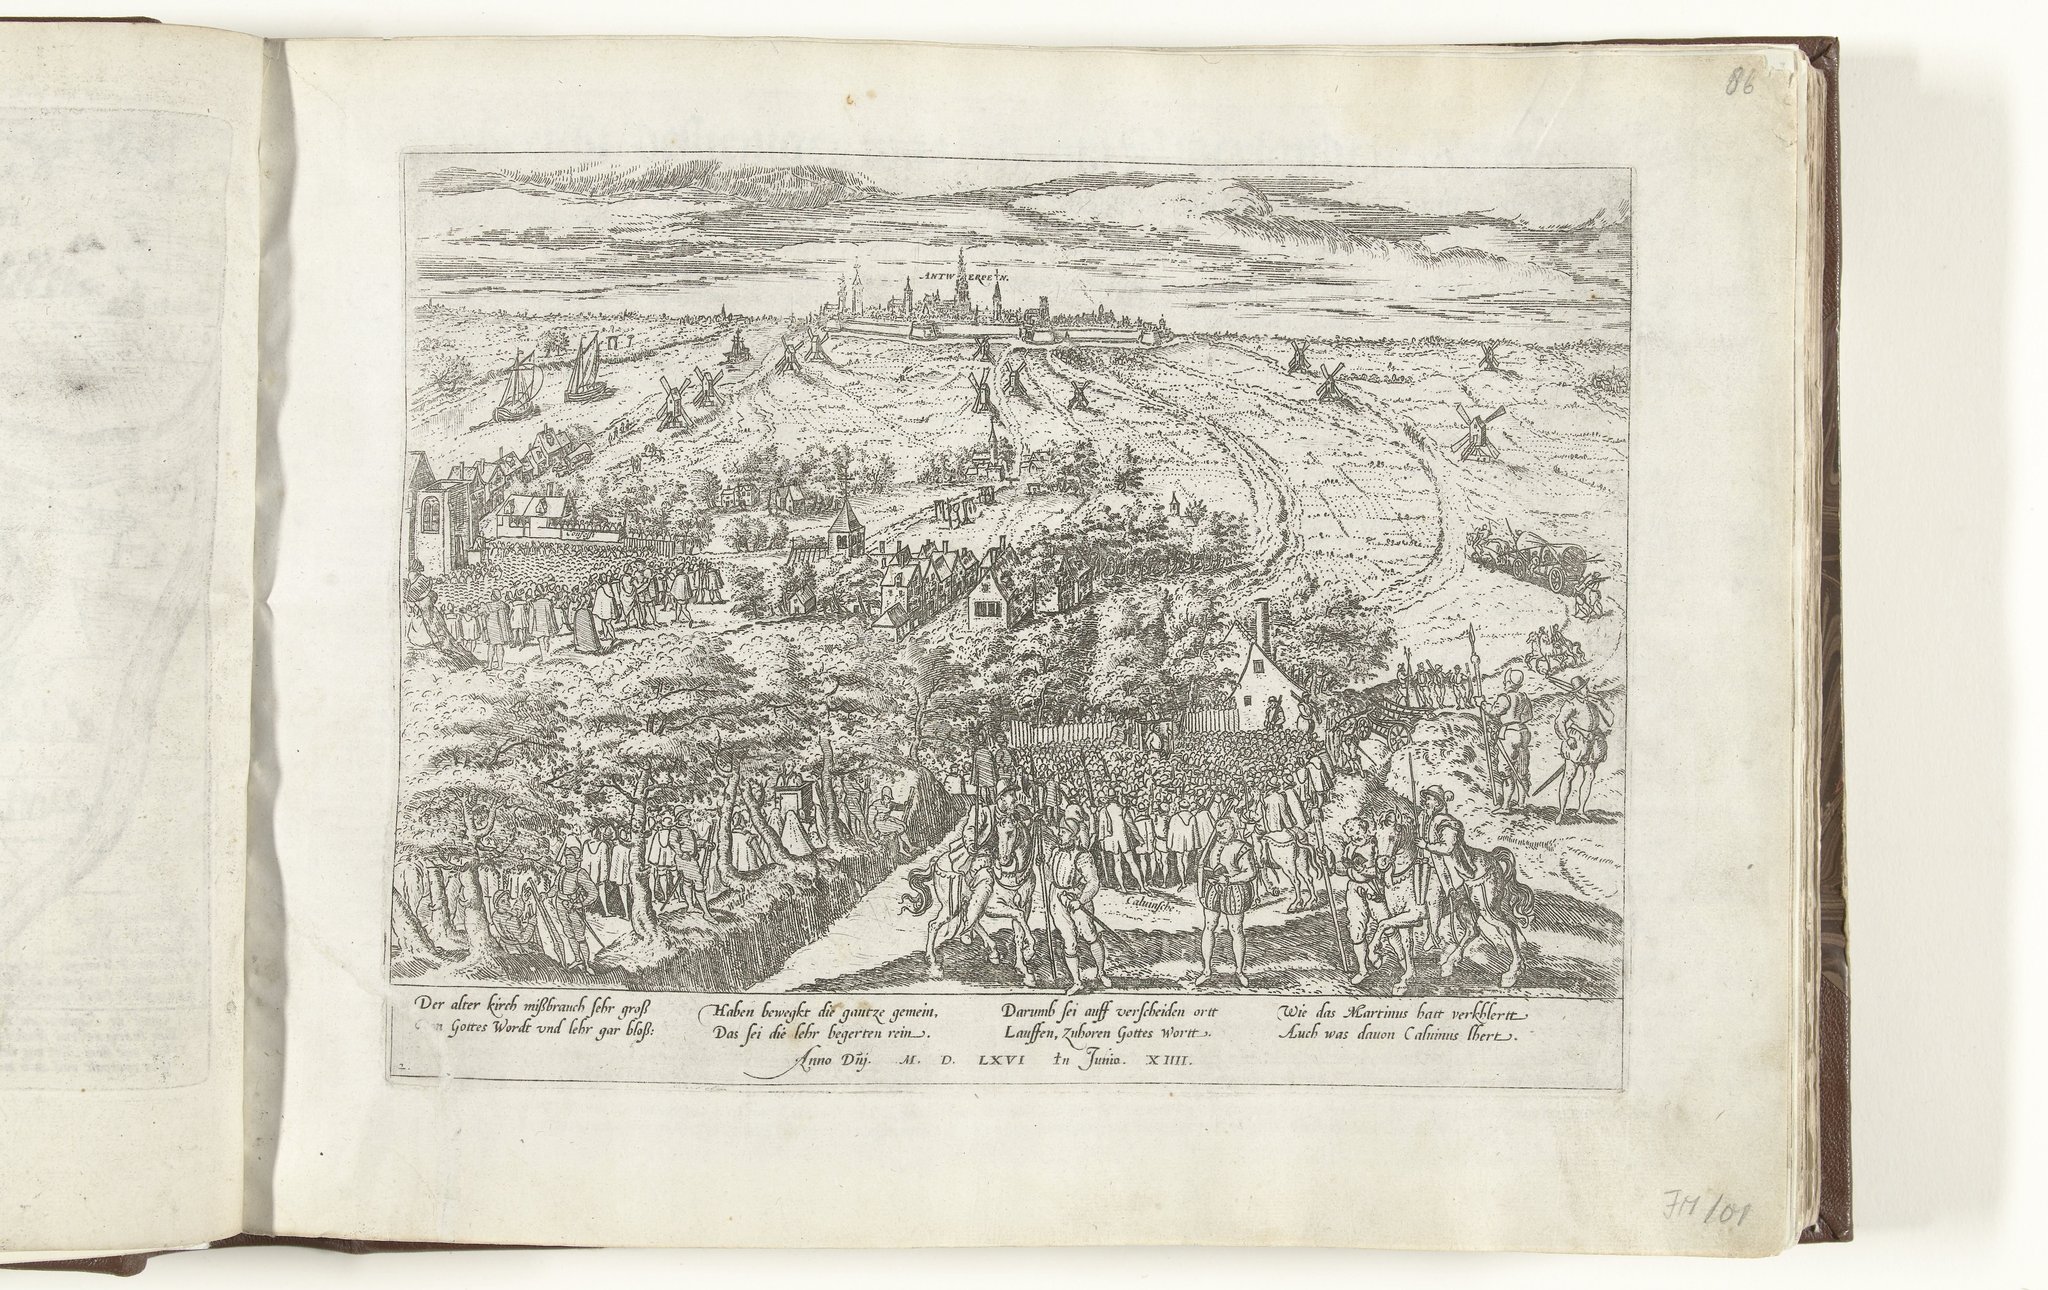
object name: print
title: Hagenpreken buiten Antwerpen, 1566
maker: frans hogenberg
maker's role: print maker, publisher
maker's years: 1538-1590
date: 1566-1570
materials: paper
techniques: etching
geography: cologne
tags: sermon ~ protestant service, antwerp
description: Hagenpreken buiten Antwerpen, 14 juni 1566. Calvinistische bijeenkomsten in de bossen, in de verte de stad Antwerpen. Op de voorgrond gewapende calvinistische ordebewakers. Met onderschrift van 8 regels in het Duits. Genummerd: 2.